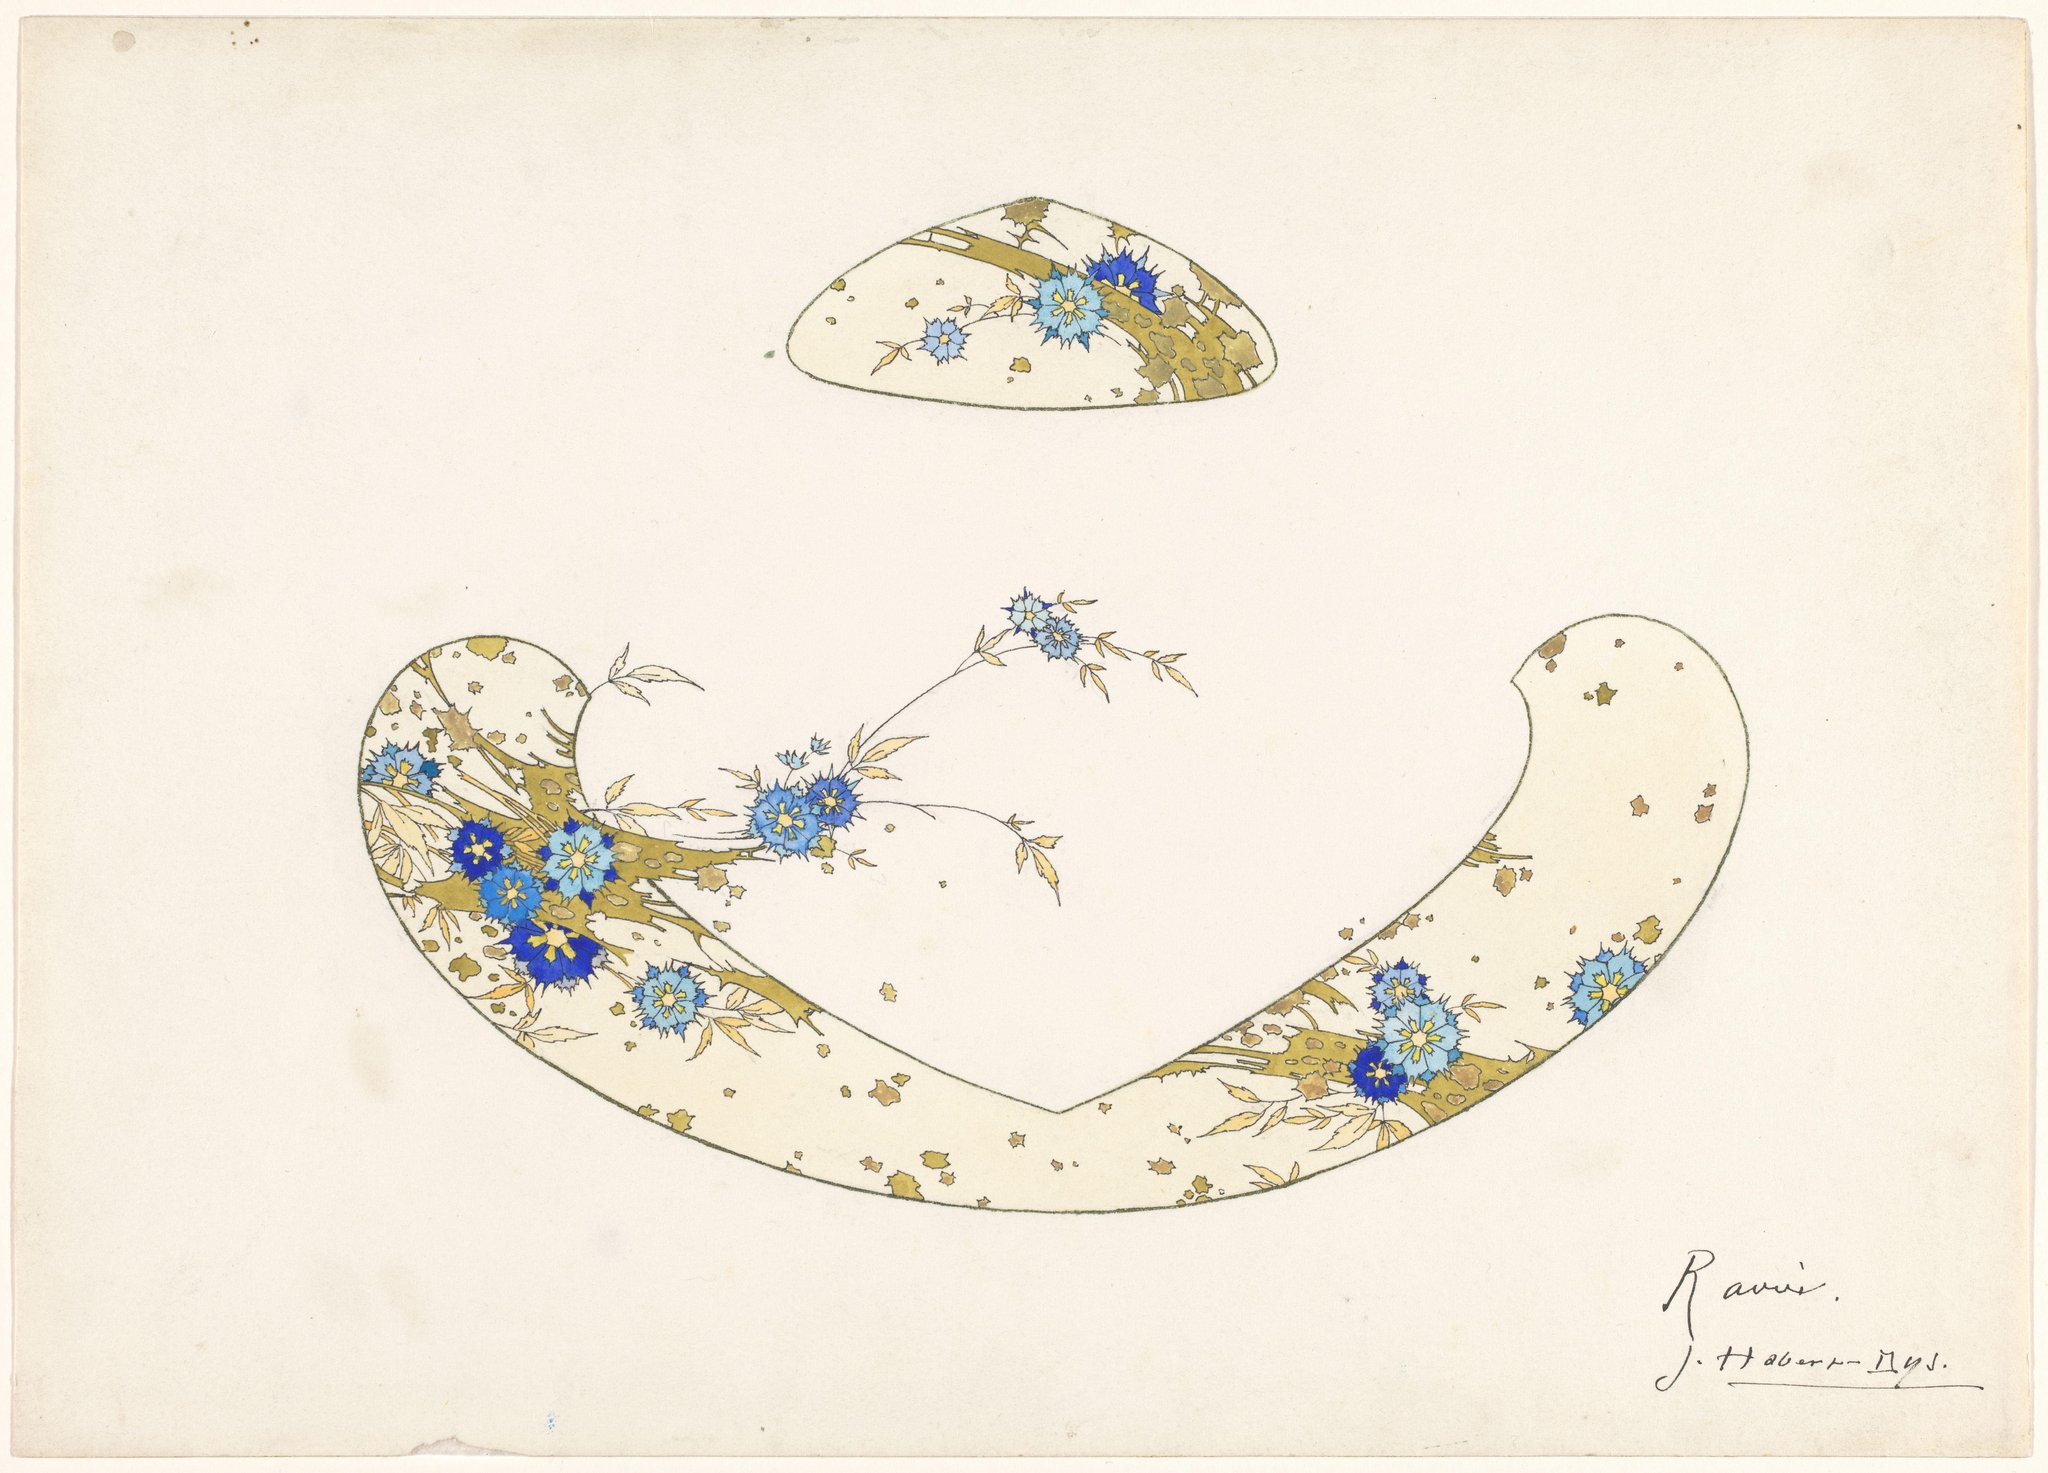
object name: drawing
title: Tien ontwerptekeningen voor een porseleinen servies voor Pillivuyt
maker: jules auguste habert-dys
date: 1889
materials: ink, paper, watercolor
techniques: brush, pen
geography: sèvres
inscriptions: signature: ‘J. Habert-Dys’, inscription: ‘Ravier’